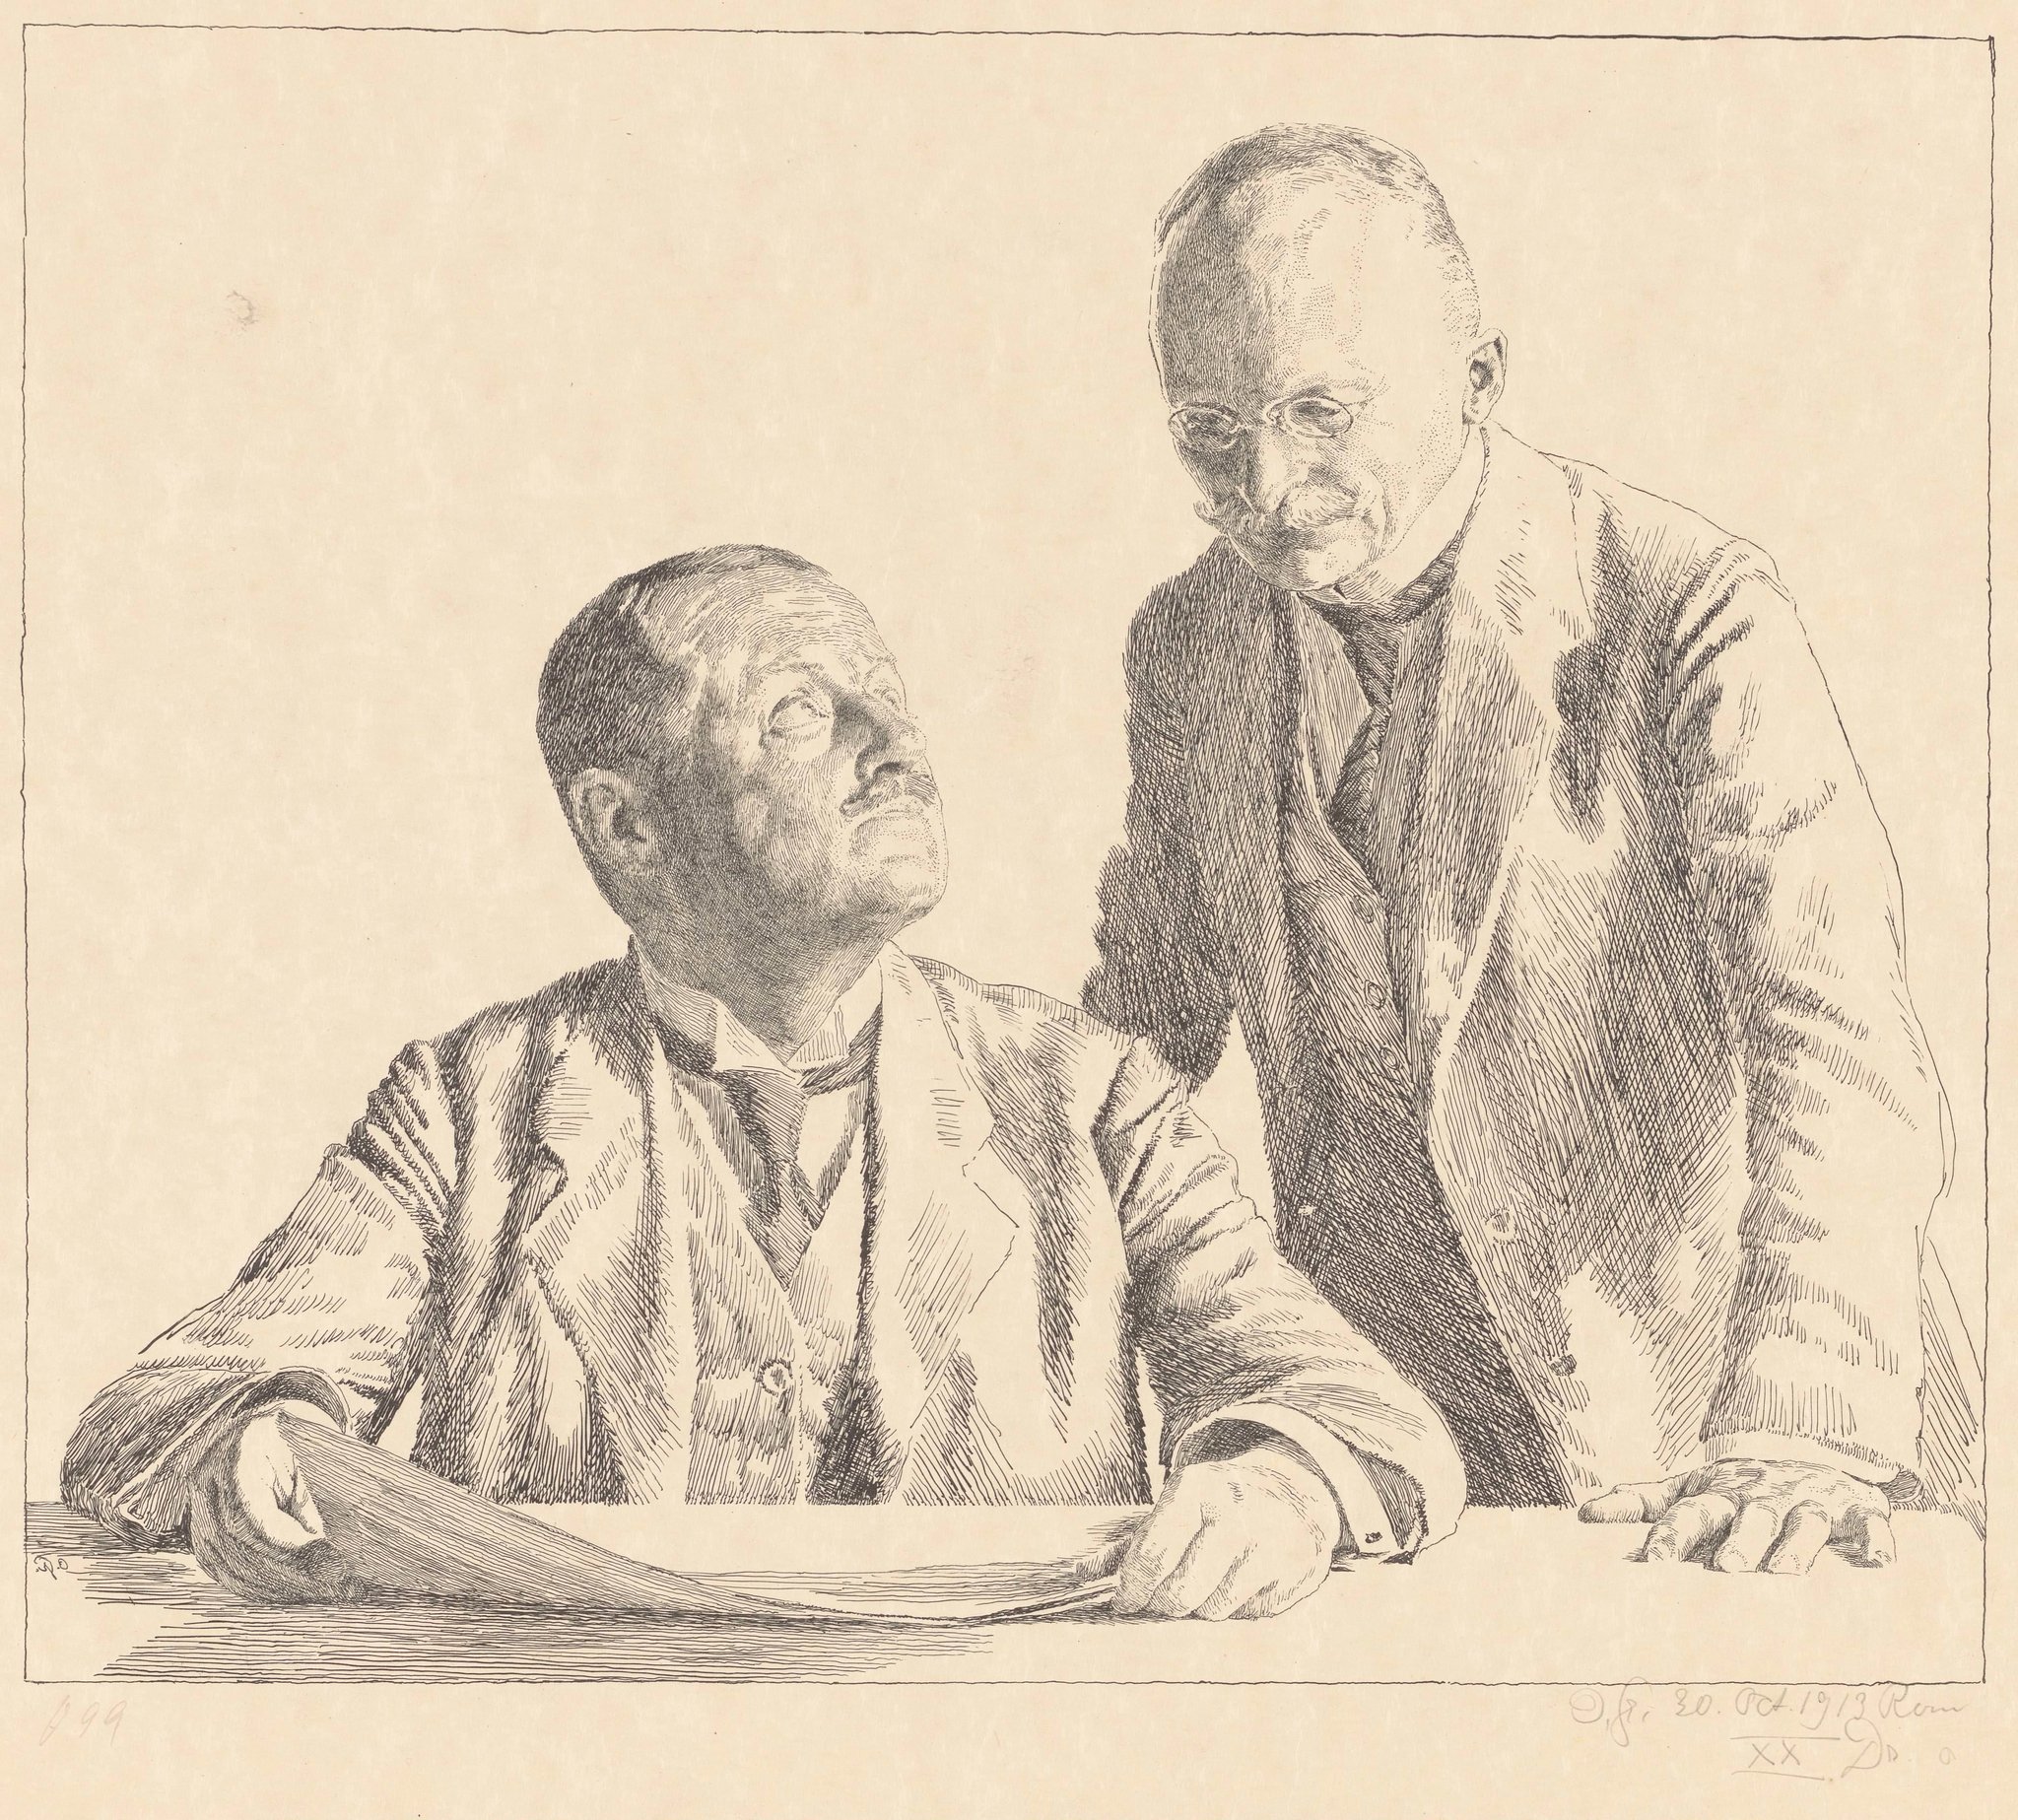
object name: print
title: Dubbelportret van de verzamelaars Guido von Usedom en Gustav von Houwald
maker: otto greiner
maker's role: print maker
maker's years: 1869-1916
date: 1913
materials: paper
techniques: lithograph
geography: rome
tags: politician, art collector (+ graphic arts)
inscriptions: signature, date and inscription: ‘O. Gr. 30 Oct. 1913 Rom / XX Dr.’, collector's mark: Lugt 4780, collector's mark: ‘Sammlung / Guido v. Usedom’